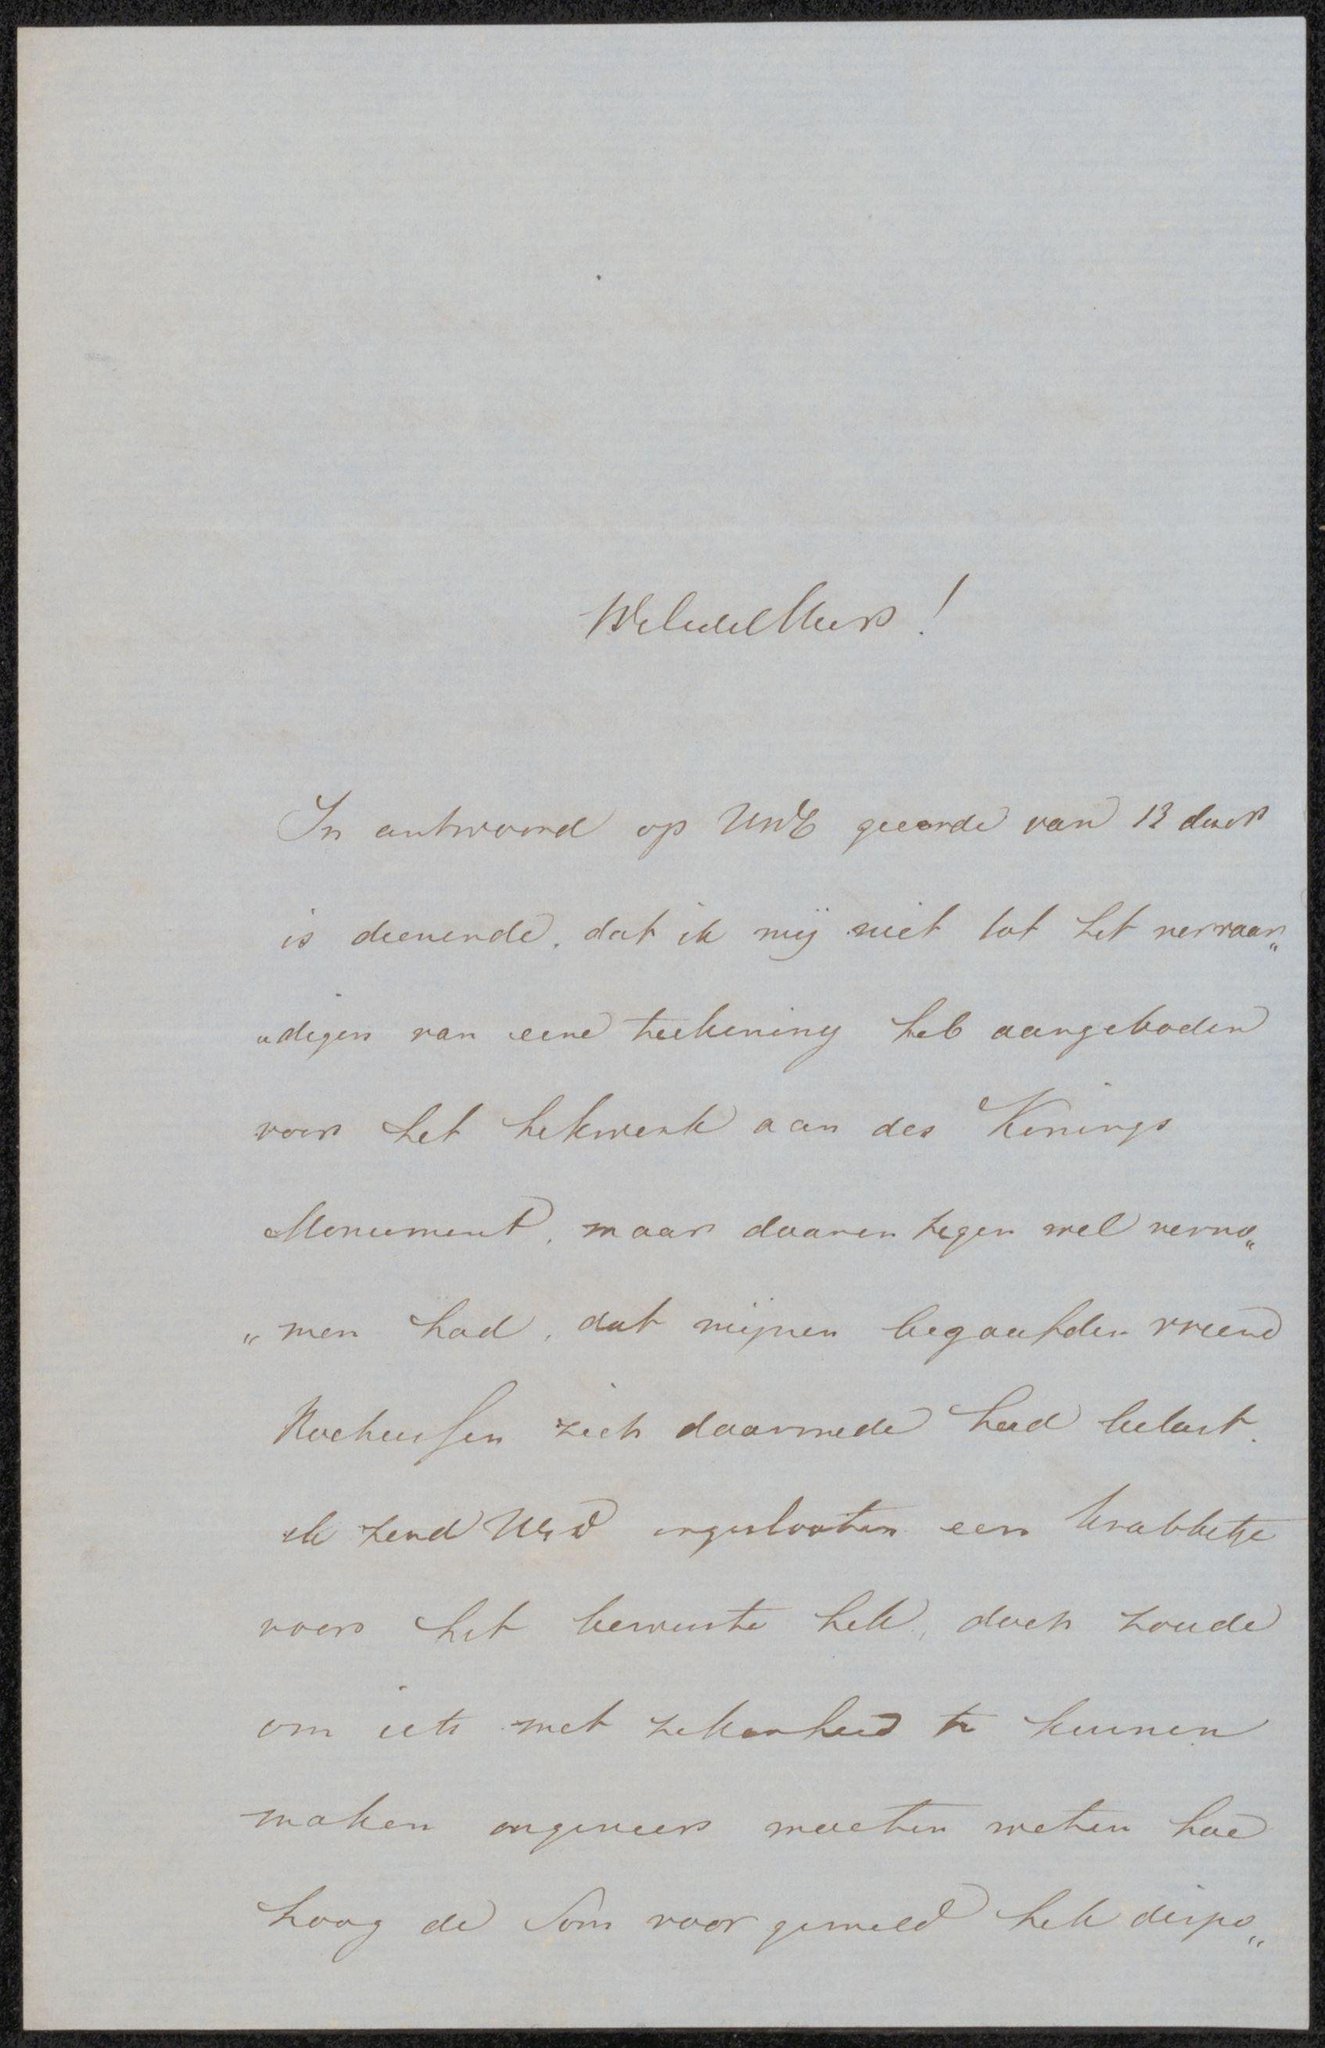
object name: letter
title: Brief aan anoniem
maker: eduard françois georges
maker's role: sculptor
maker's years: 1817-1895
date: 1859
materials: ink, paper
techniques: pen, writing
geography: utrecht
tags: drawing, money